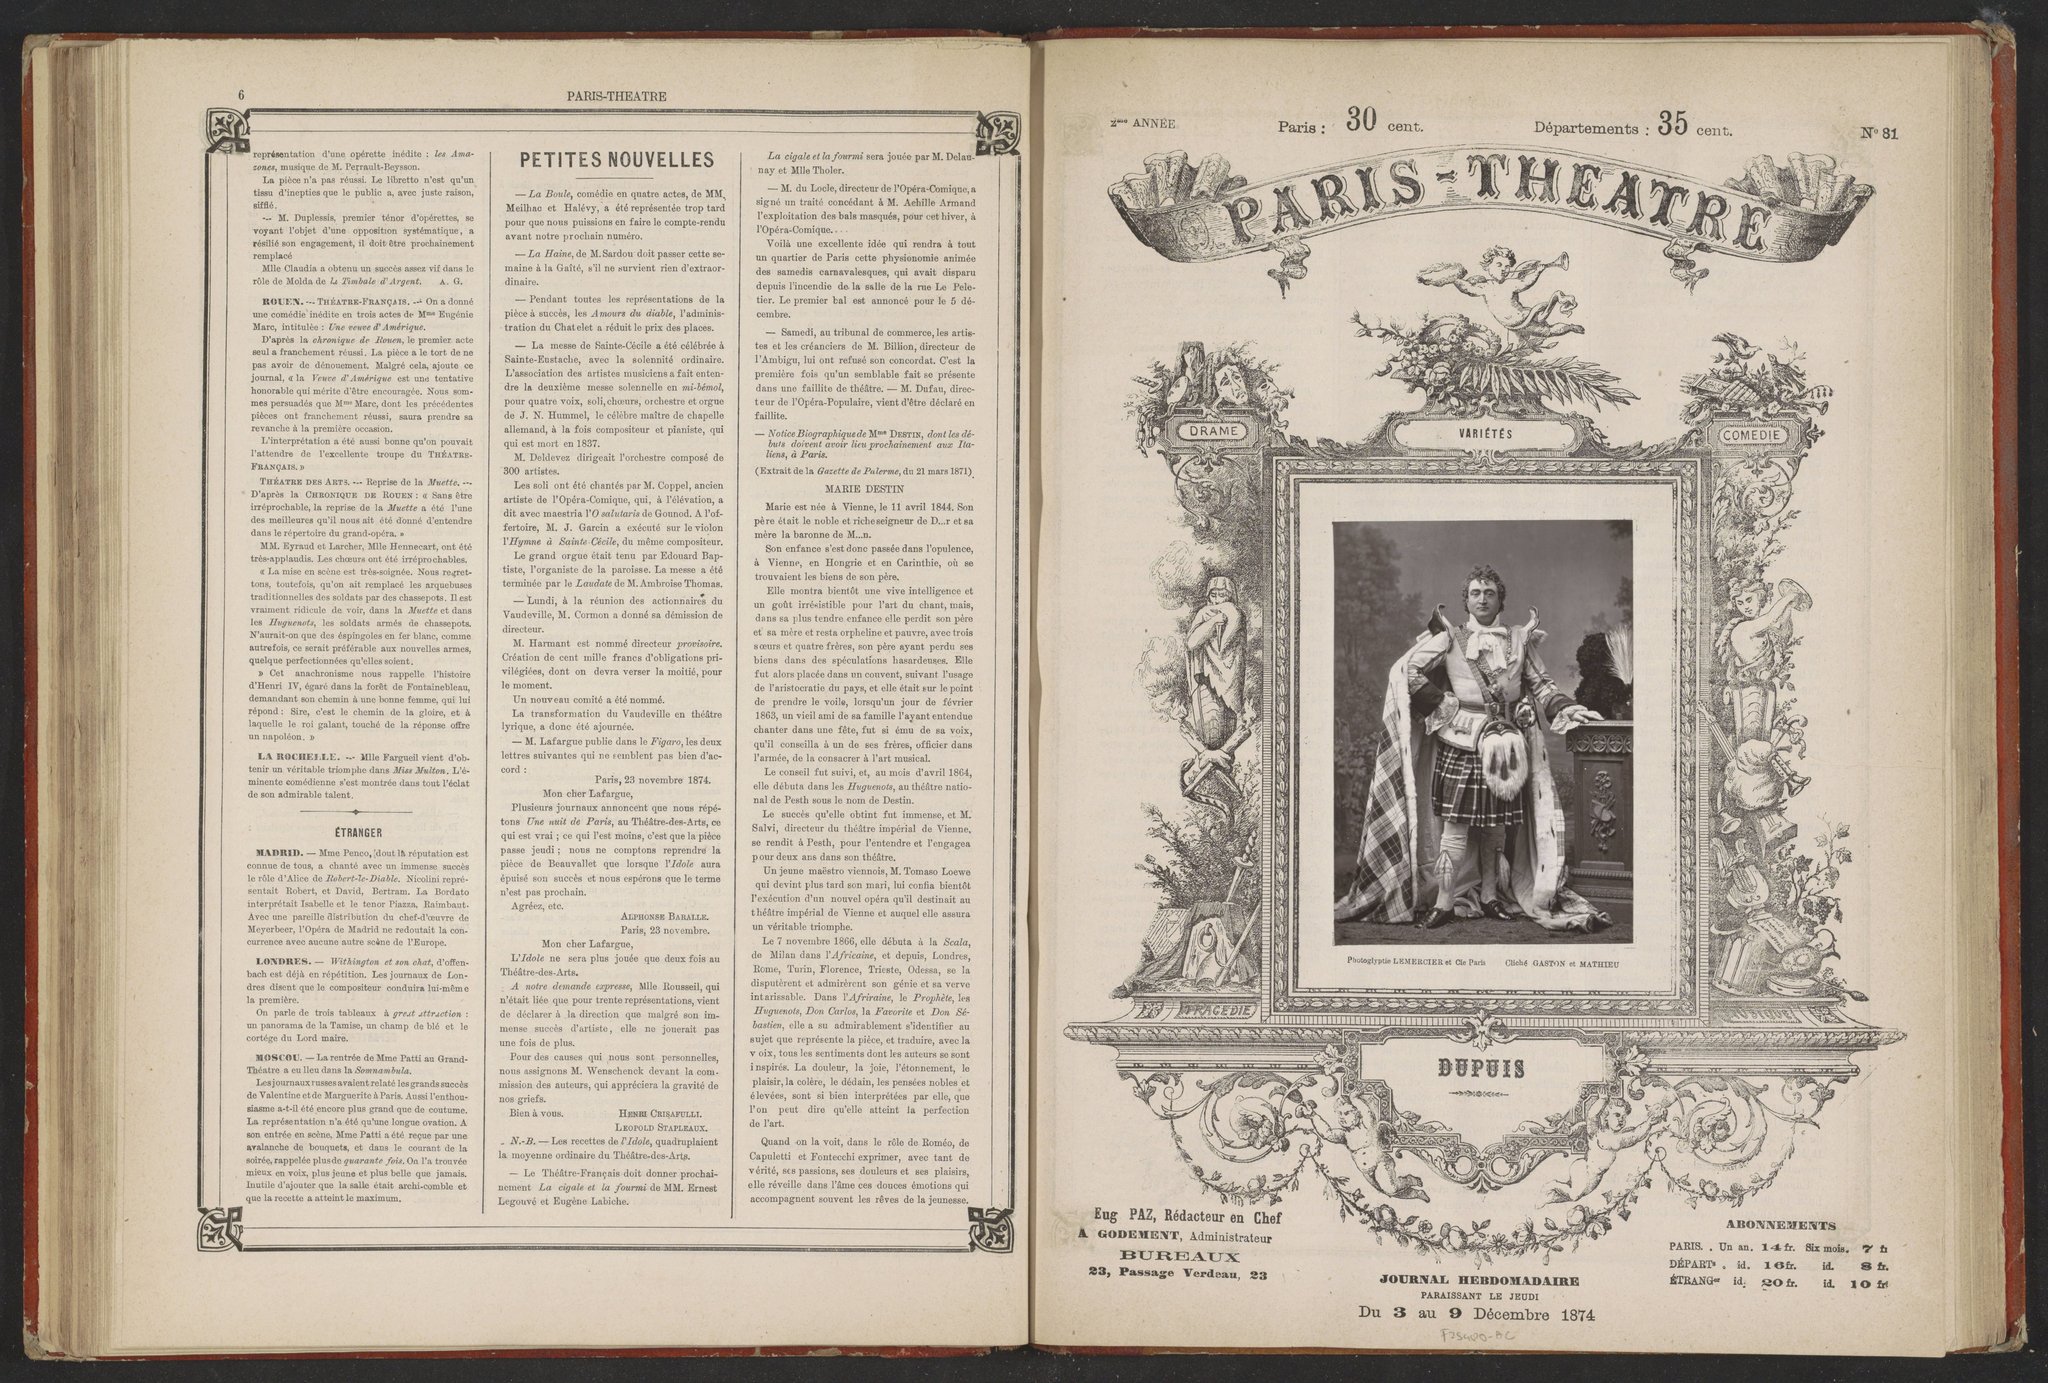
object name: page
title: Portret van José Dupuis in Schotse kledij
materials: paper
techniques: woodburytype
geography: paris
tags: portrait of actor, actress, folk costume, regional costume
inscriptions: inscription: ‘Journal hebdomadaire paraissant le jeudi Du 3 au 9 Décembre 1874’, number: ‘No 81’